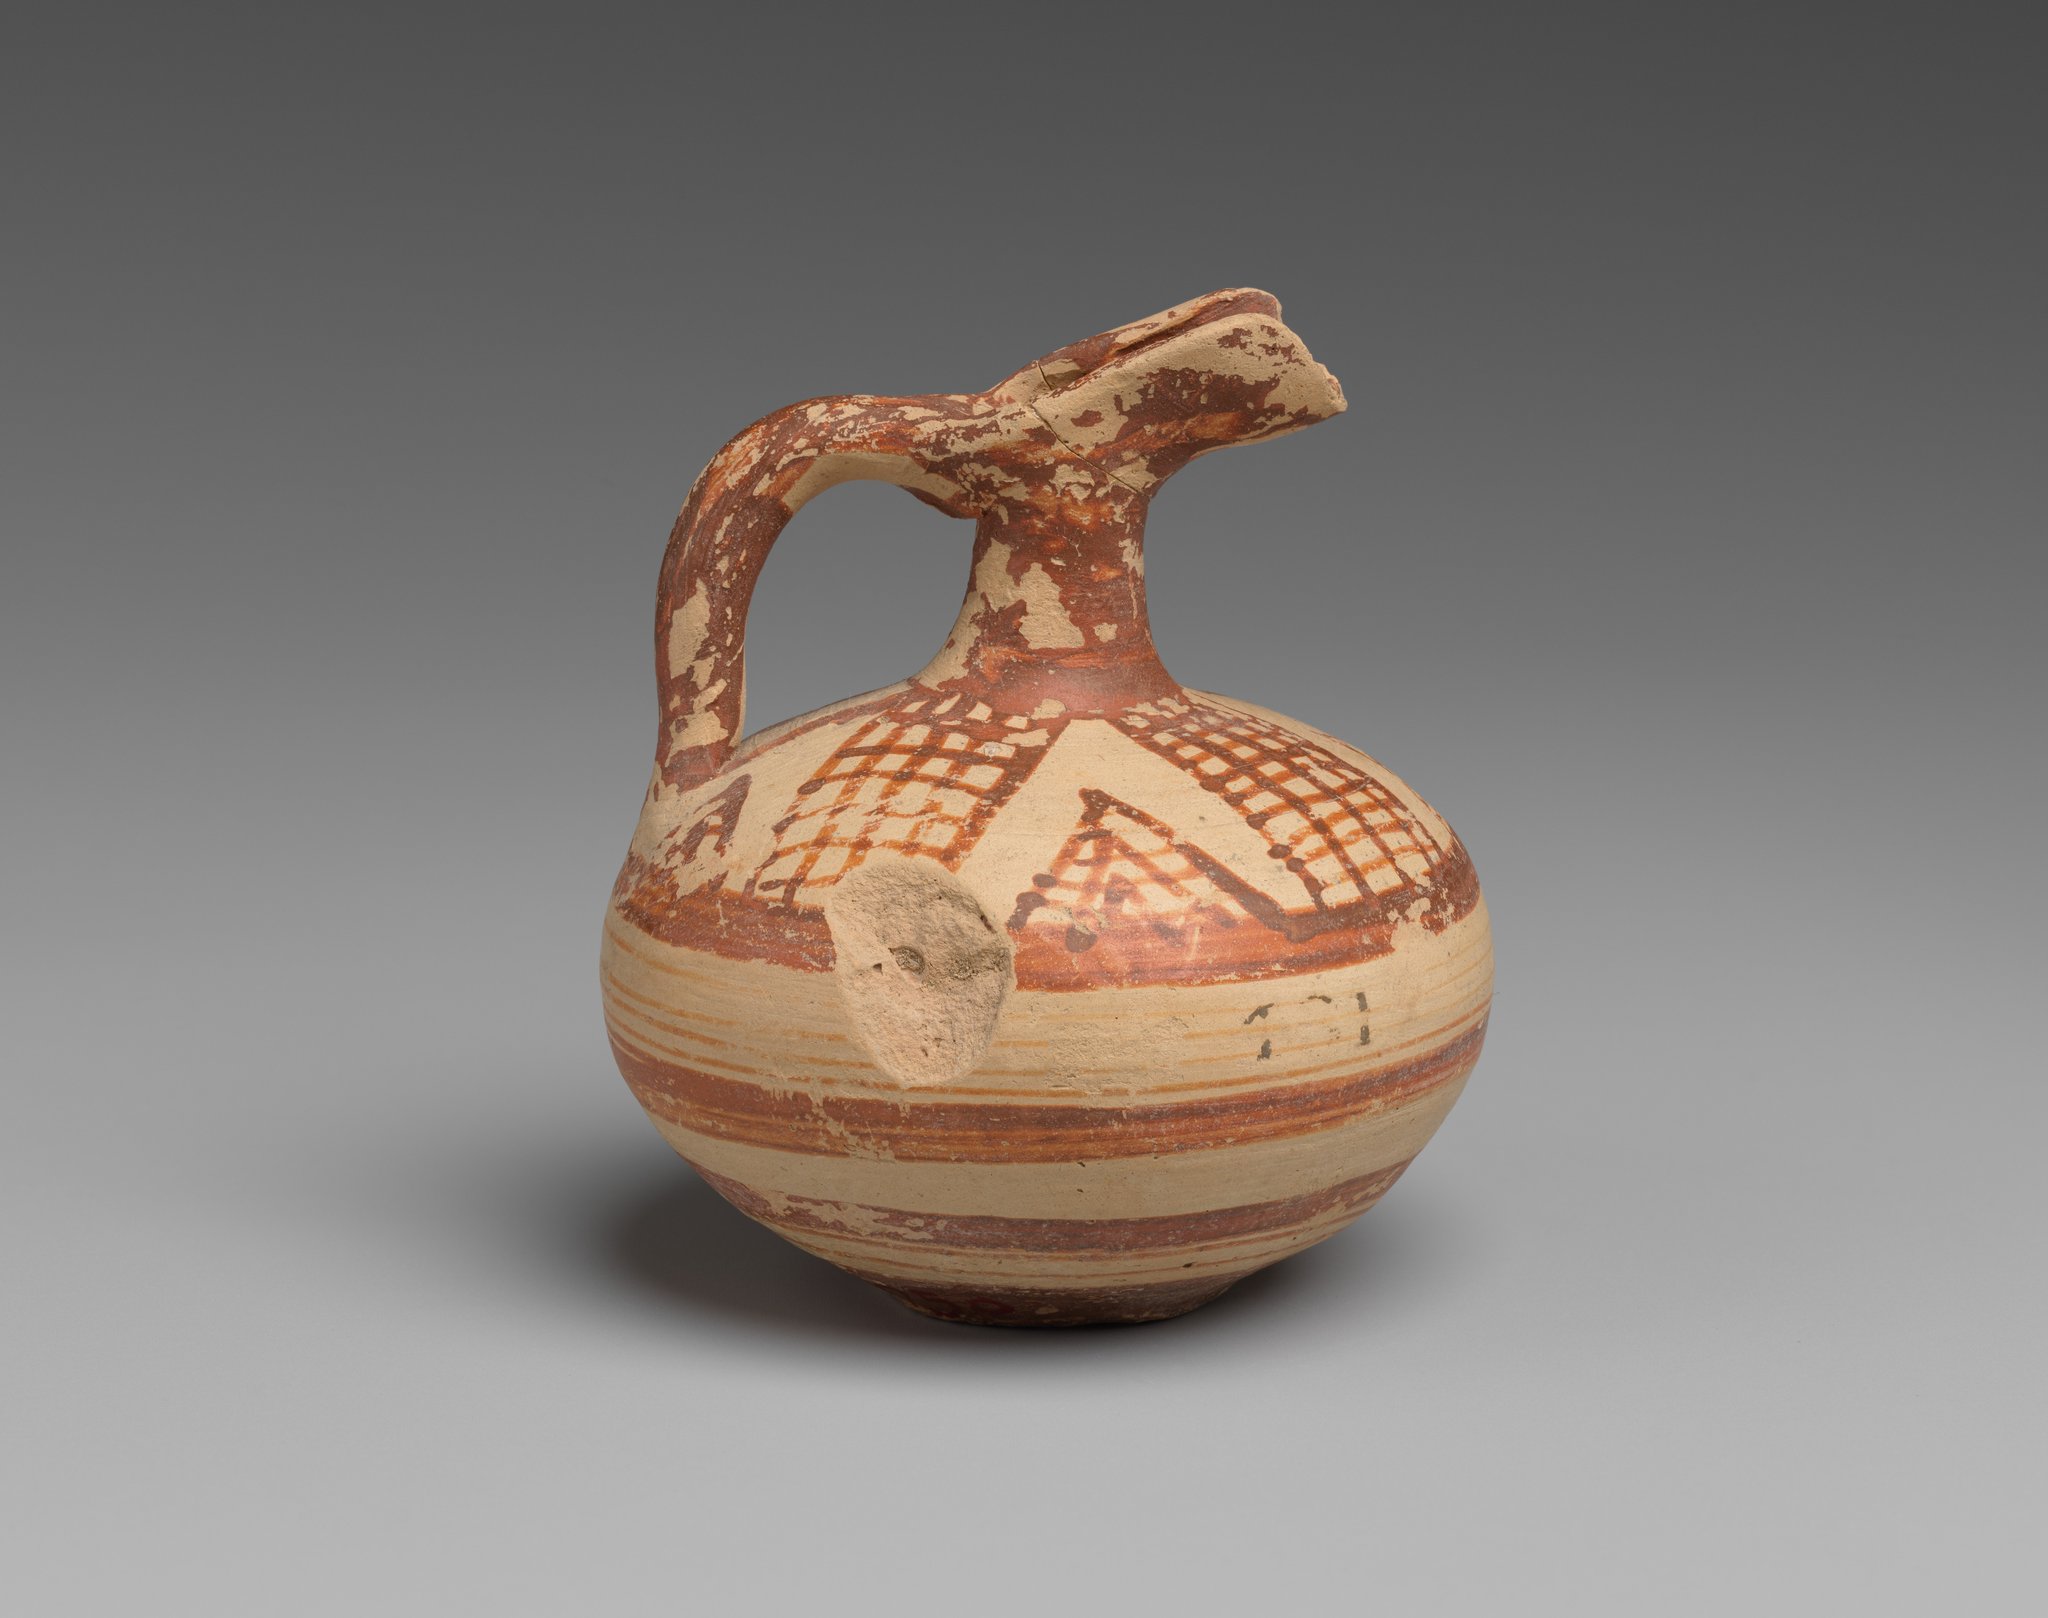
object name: jug, beak spouted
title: Terracotta beak-spouted jug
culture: aegean, helladic or mycenaean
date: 1300-1200 BCE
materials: terracotta